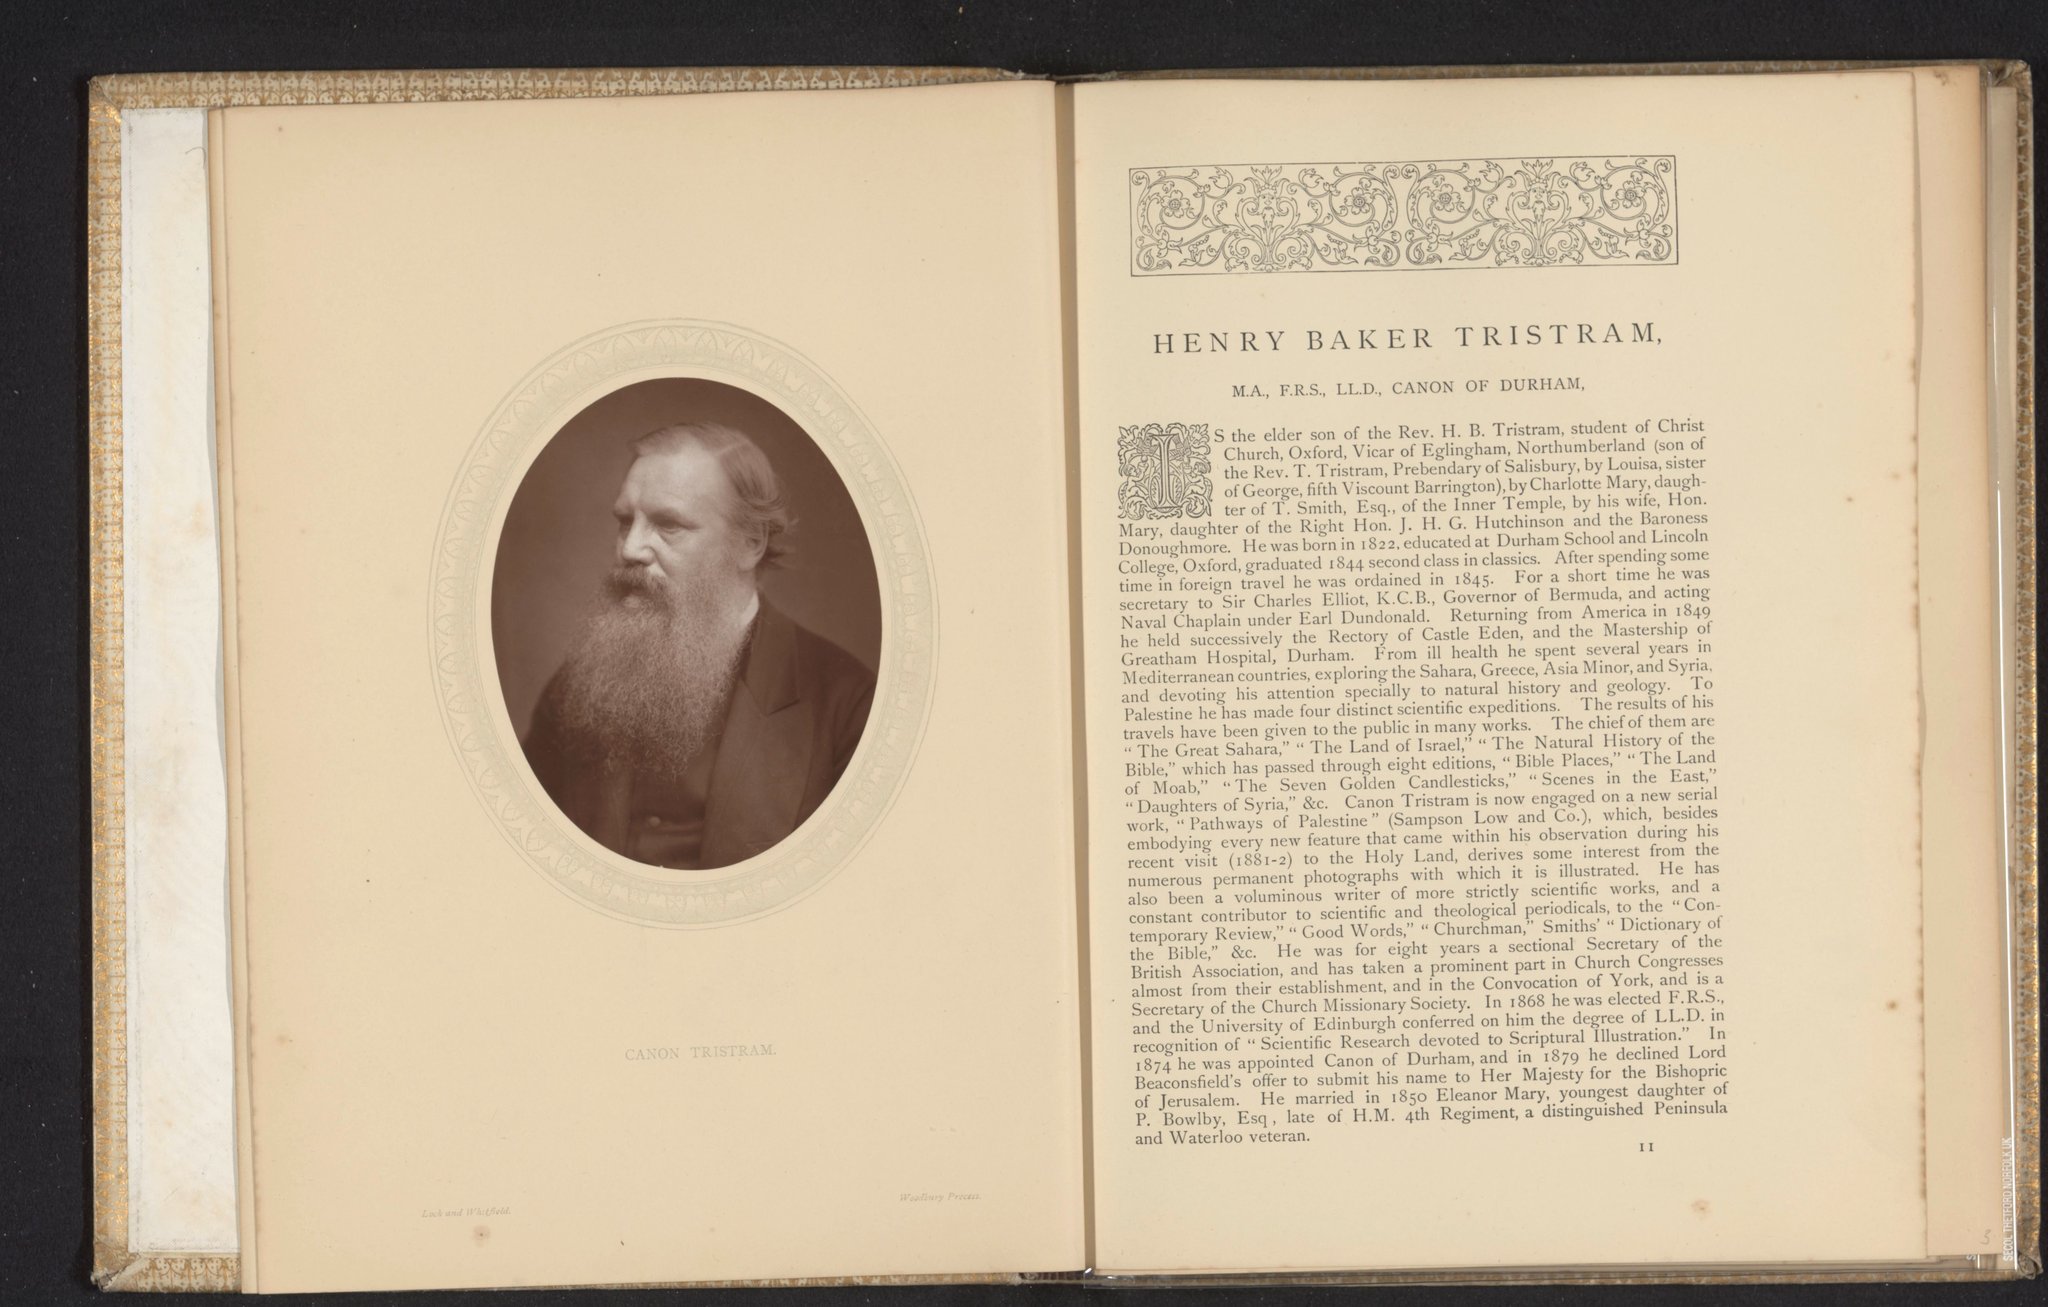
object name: photomechanical print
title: Canon Tristram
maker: Anonymous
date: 1878-1883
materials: paper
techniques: woodburytype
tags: henry baker tristram, historical persons (portraits and scenes from the life) (+ (full) bust portrait), functionaries and dignitaries ~ protestant churches